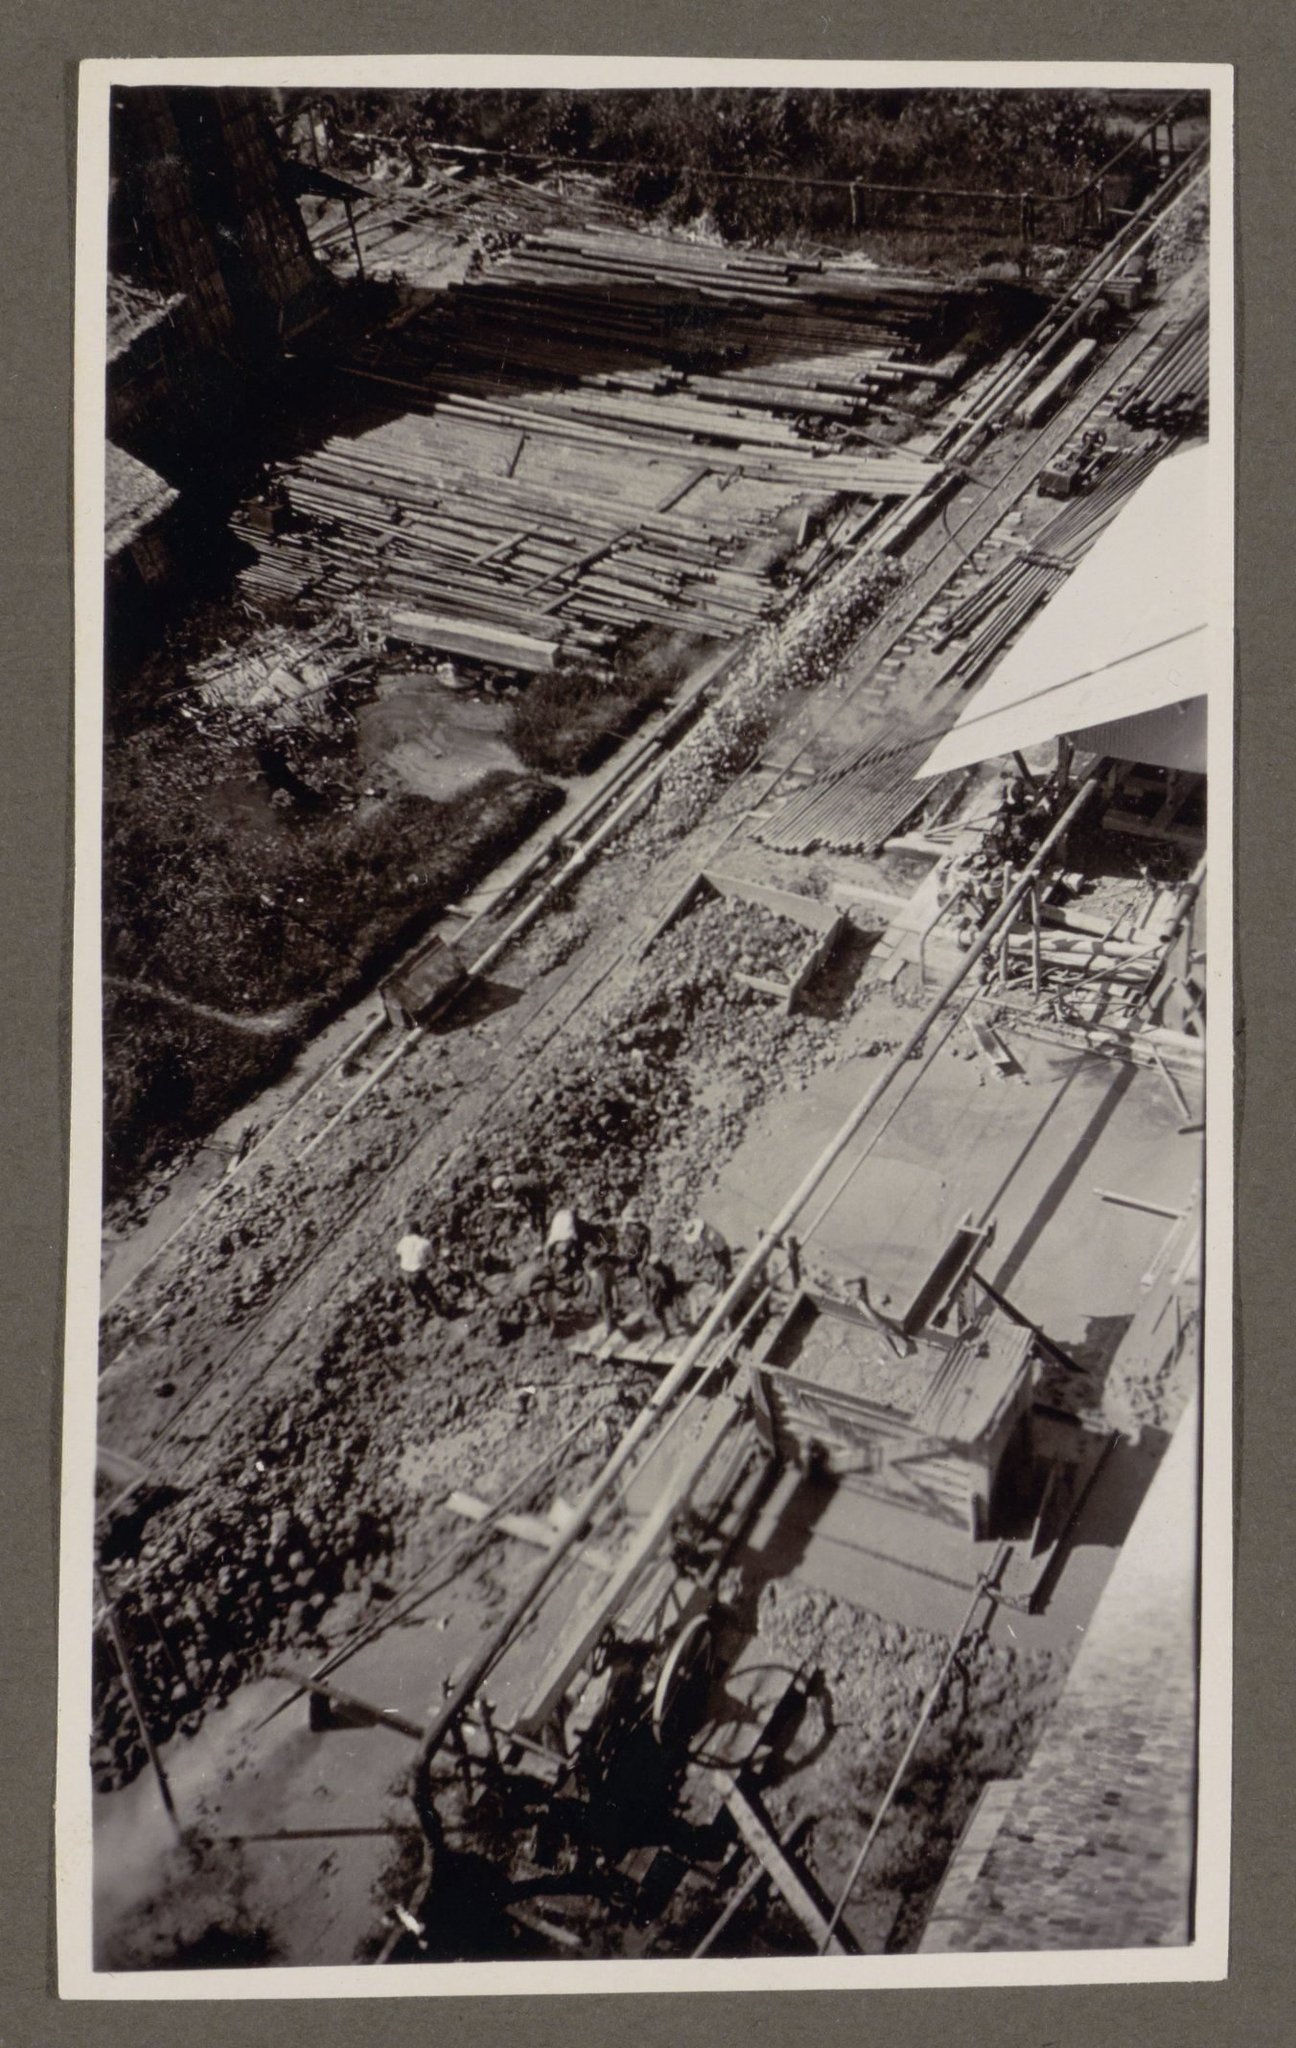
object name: photograph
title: Houtopslag en apparatuur, van bovenaf gezien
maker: Anonymous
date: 1920-1930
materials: photographic support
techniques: gelatin silver print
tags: storage space, dutch east indies, the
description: Onderdeel van familiealbum Nederlands-Indië.